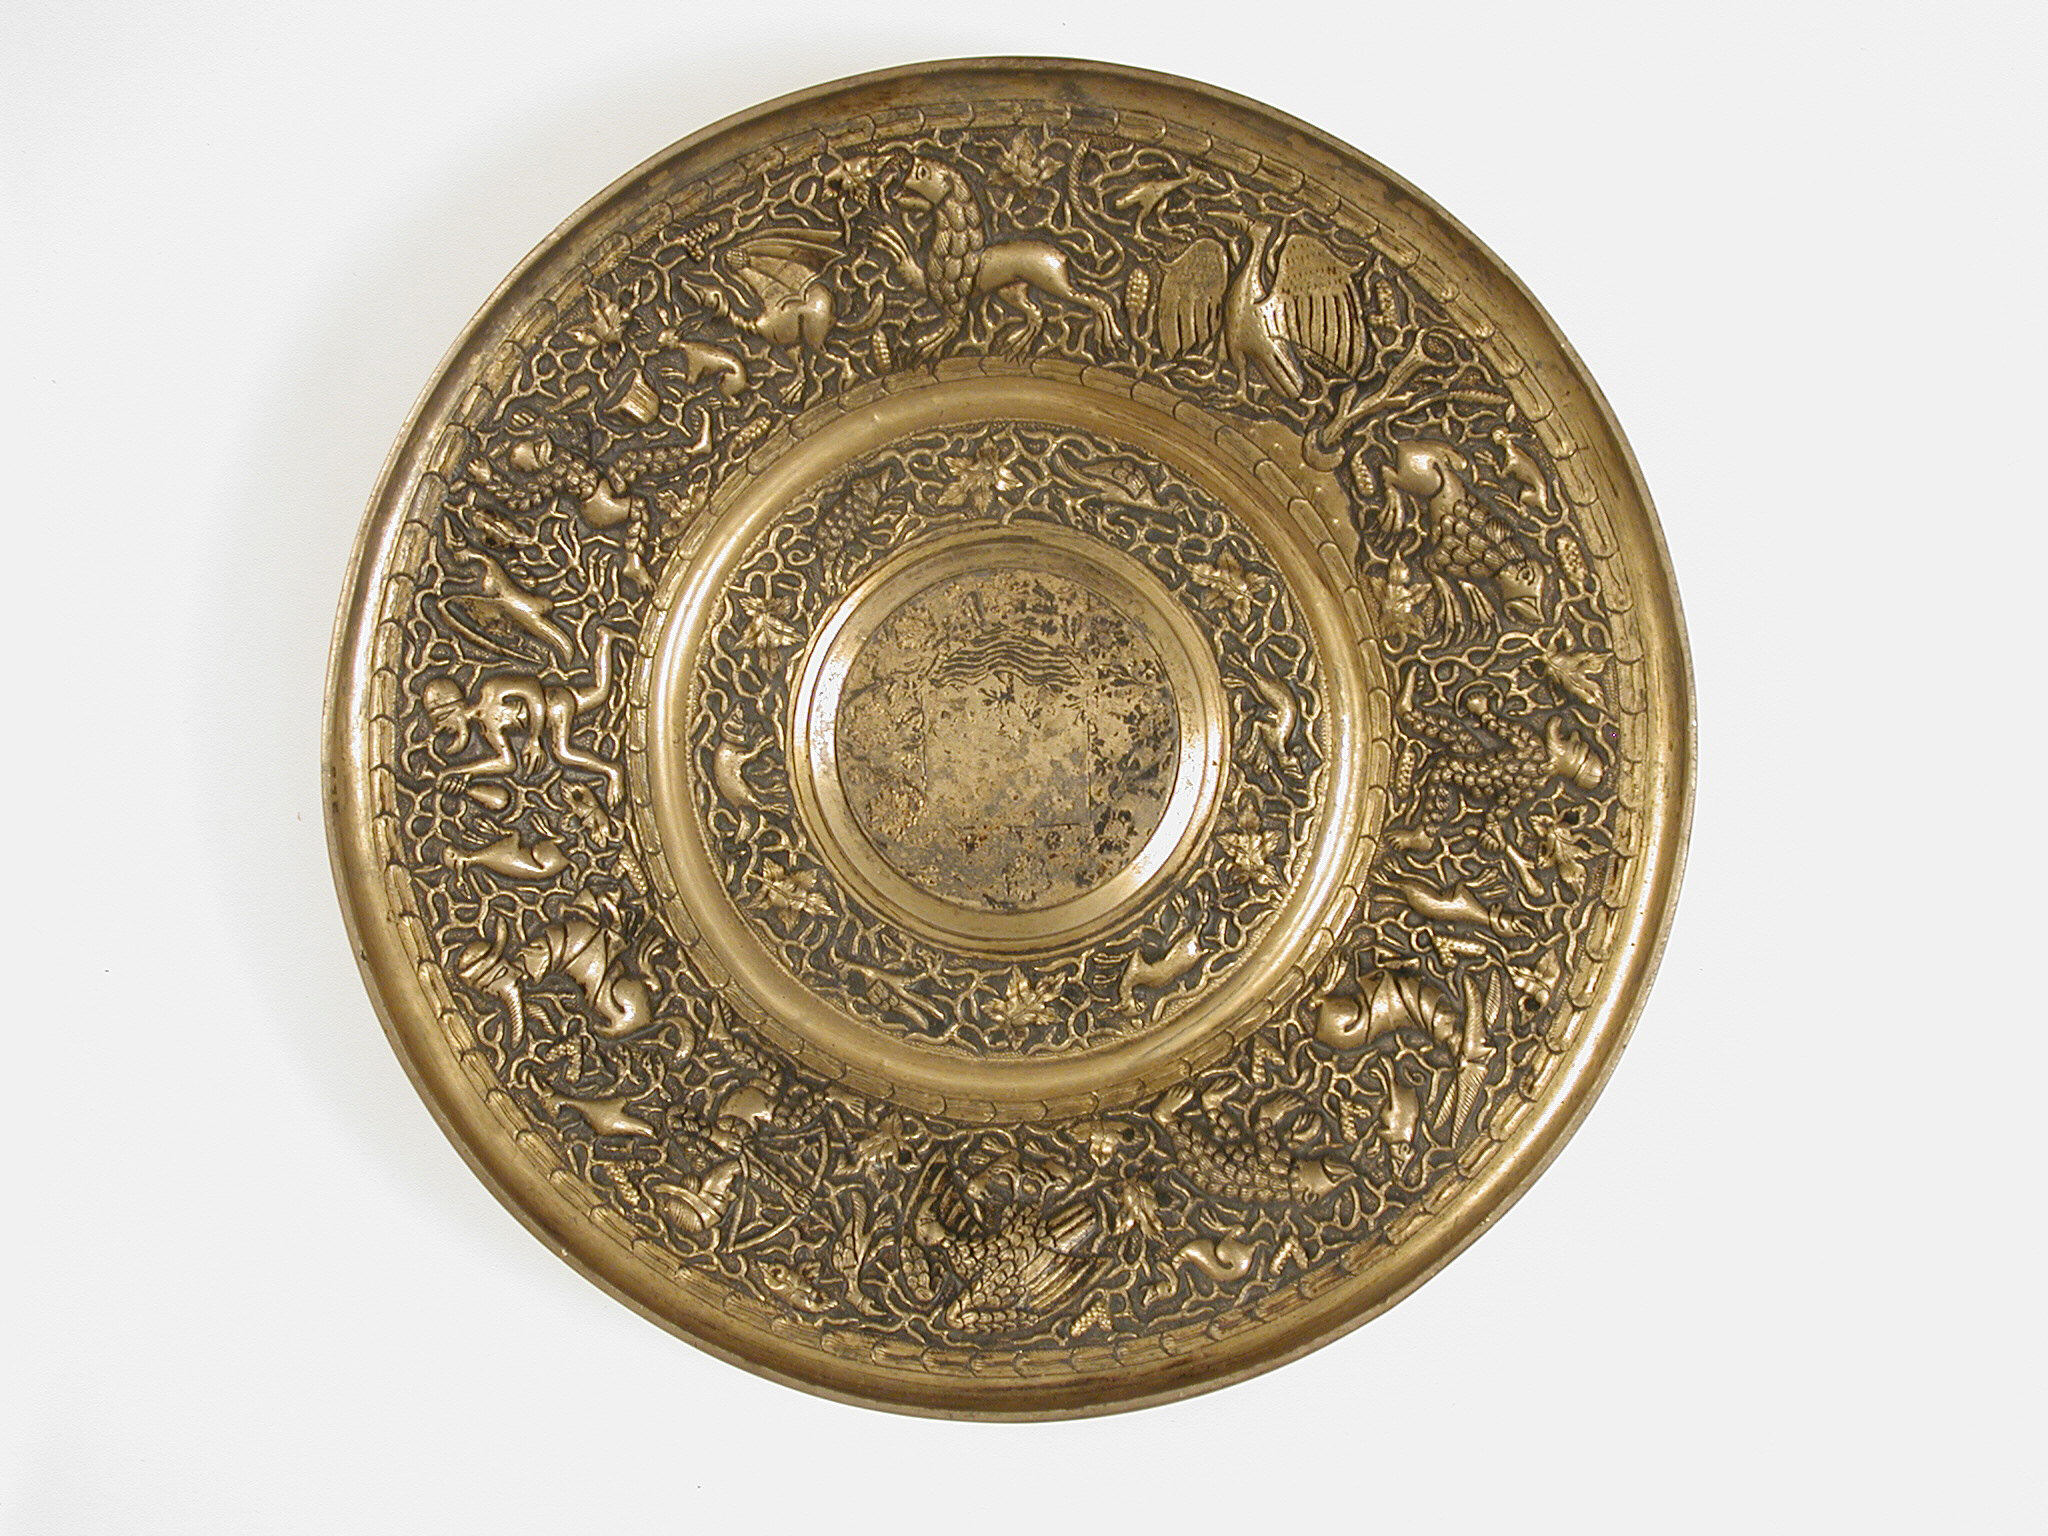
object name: plate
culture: spanish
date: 1801-1900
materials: brass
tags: birds,men